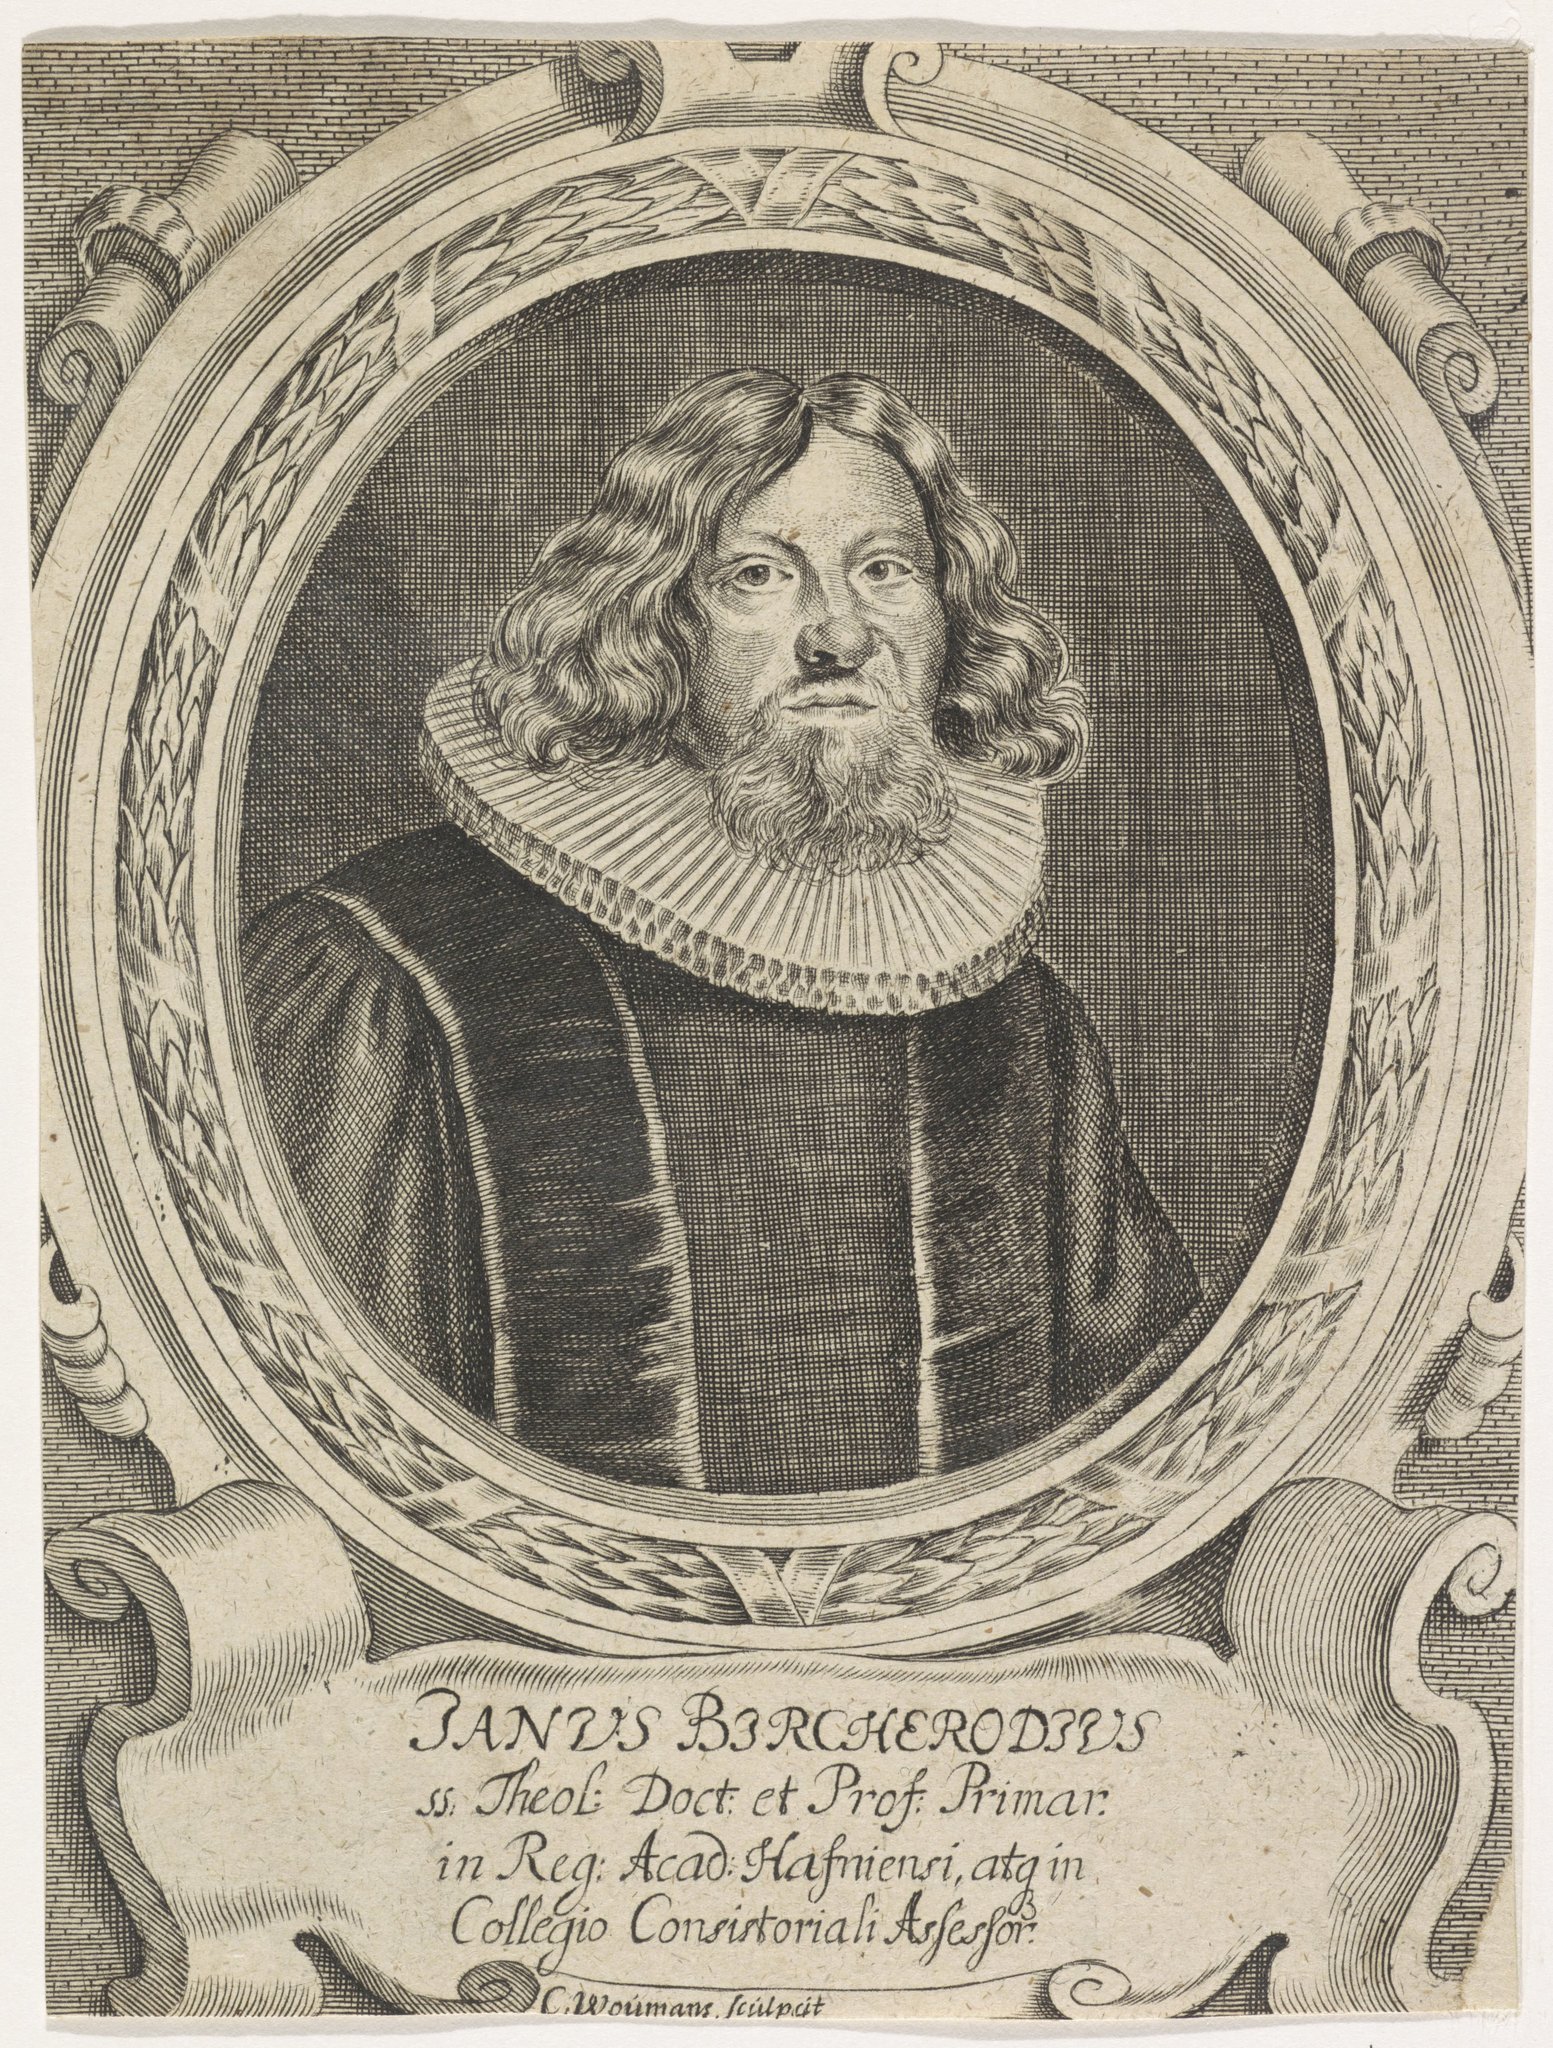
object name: print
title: Portret van de theoloog Jens Bircherod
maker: coenraet waumans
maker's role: draughtsman, print maker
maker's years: 1619-1681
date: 1690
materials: paper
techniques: engraving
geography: antwerp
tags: schrijver, theoloog, professor, jens bircherod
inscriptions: collector's mark: Lugt 2228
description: Prent gebruikt in: Bicherod, Jens. Synopsis locorum communium theologicorum, in qua veritas religionis christianæ ex sacris literis & orthodoxis theologis sequenti methodo proponitur ... Frankfurt: Johannis Justi Erytropili, 1690.